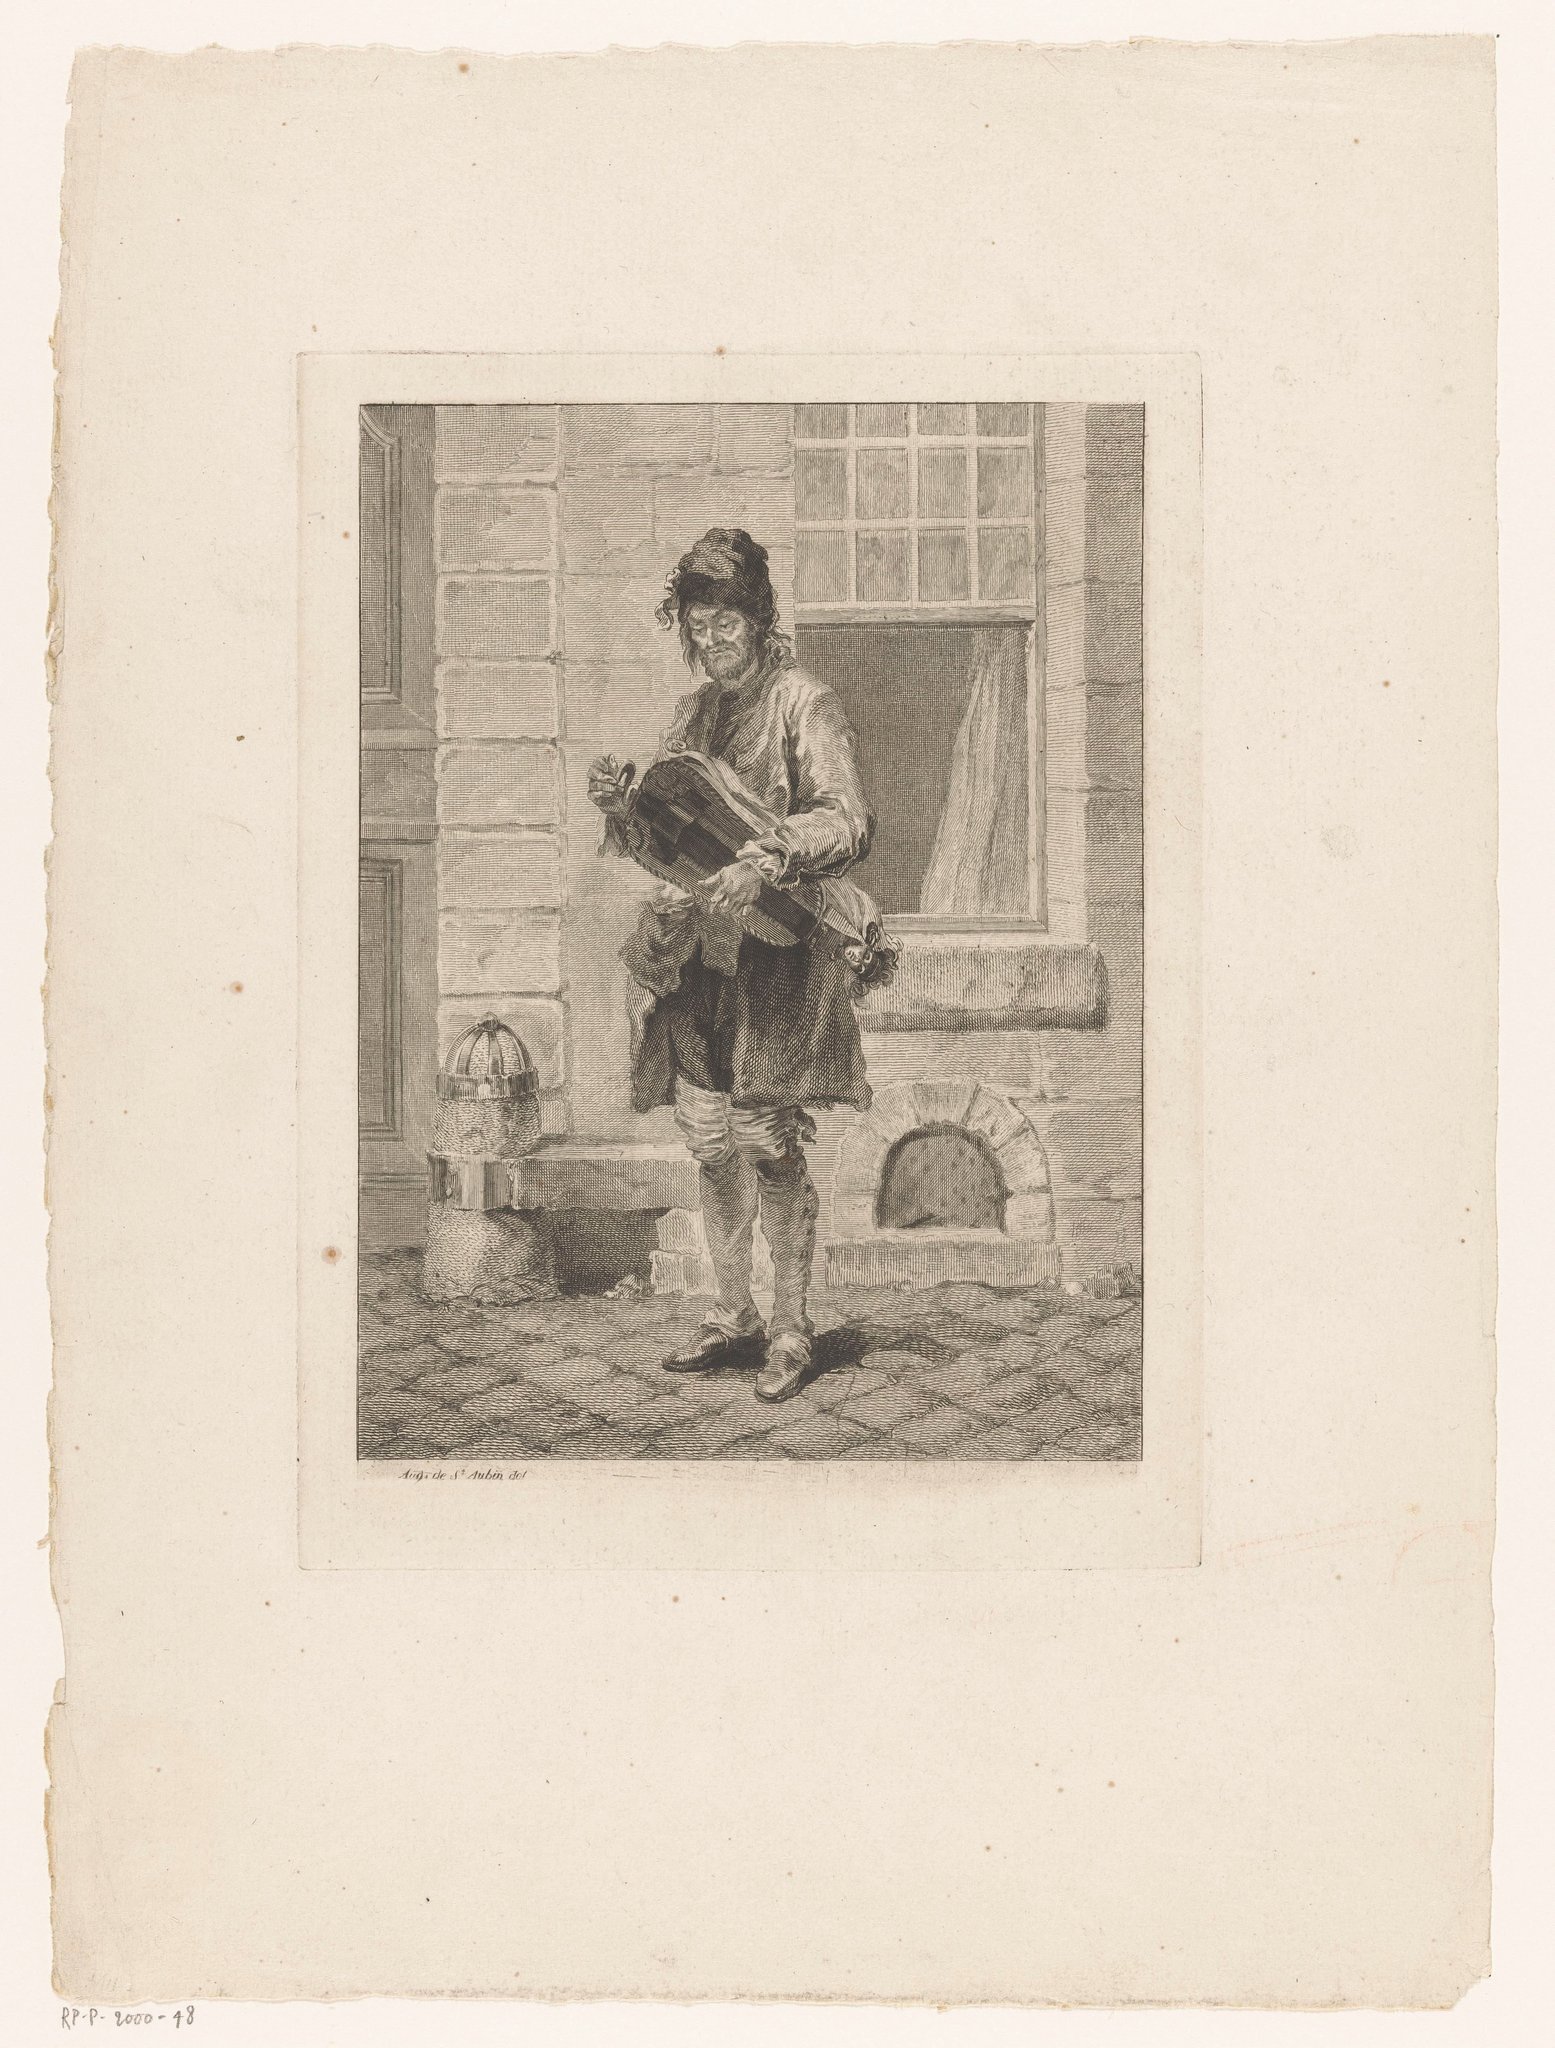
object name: print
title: Straatmuzikant met een draailier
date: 1766-1770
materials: paper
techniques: engraving, etching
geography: france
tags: hurdy-gurdy, 'fahrende leute', vagrants, hurdy-gurdy player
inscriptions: collector's mark: Lugt 2760, signature: ‘Aug. de St. Aubin del’, collector's mark: Lugt 2228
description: Maakt deel uit van een serie getiteld: "Mes Gens, ou les Commissionaires ultramontains, Les Savoyards", uitgegeven door Basan en de Saint-Aubin. De serie bestaat uit zes platen en een frontispice. Bij een latere editie is een achtste plaat toegevoegd.